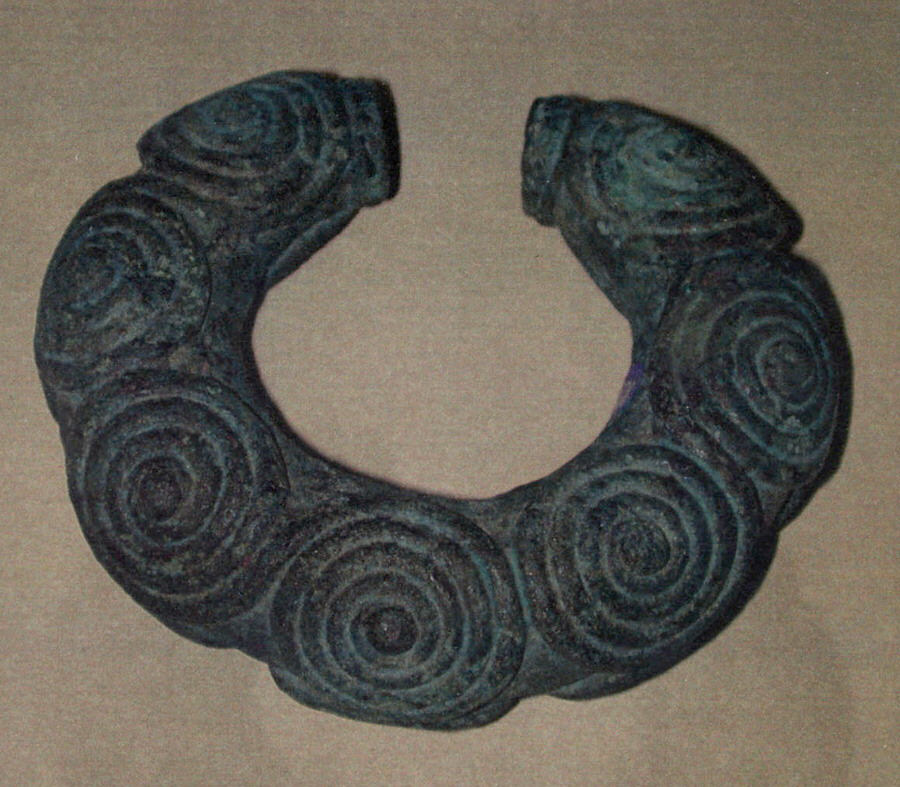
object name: bangle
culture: vietnamese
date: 500 BCE-300 CE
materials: bronze